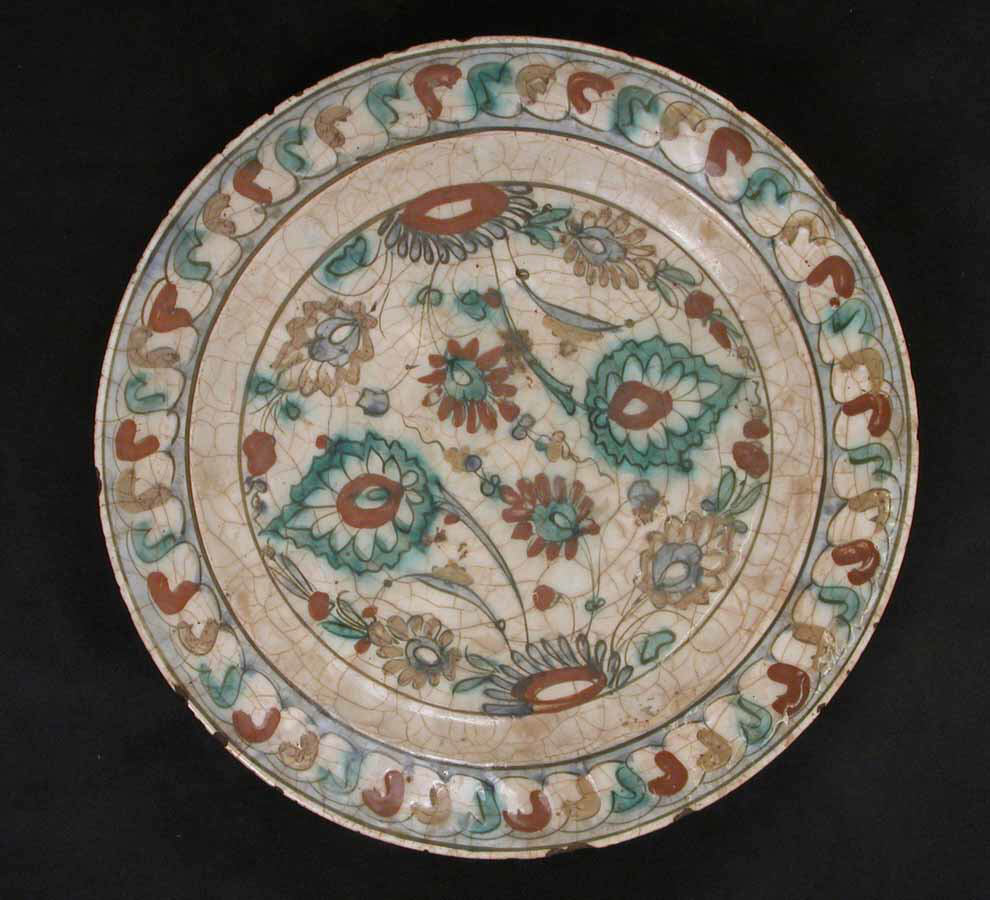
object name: dish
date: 1601-1700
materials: stonepaste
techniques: painting, underglaze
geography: iran